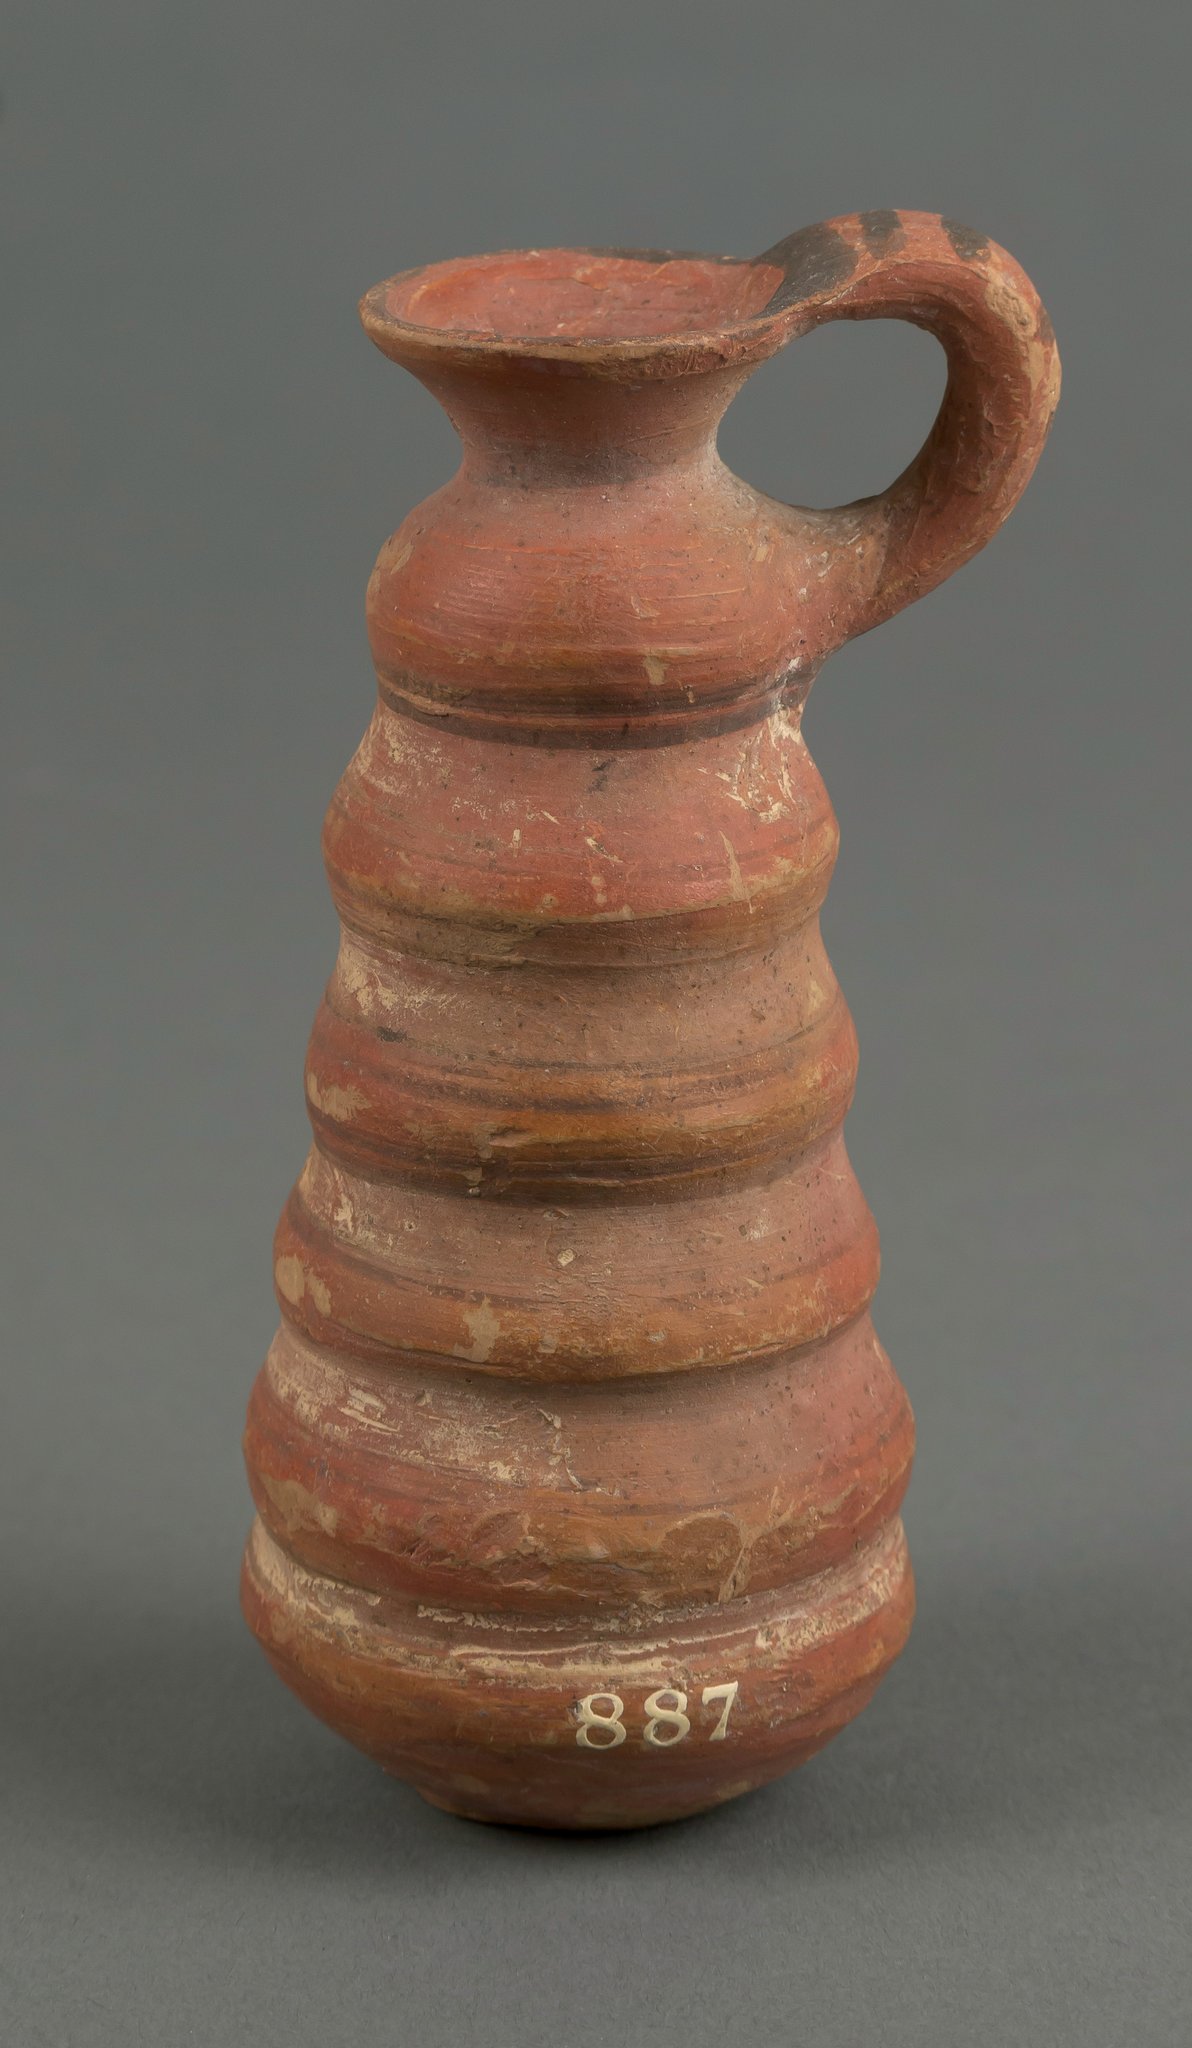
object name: juglet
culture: cypriot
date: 750-600 BCE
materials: terracotta